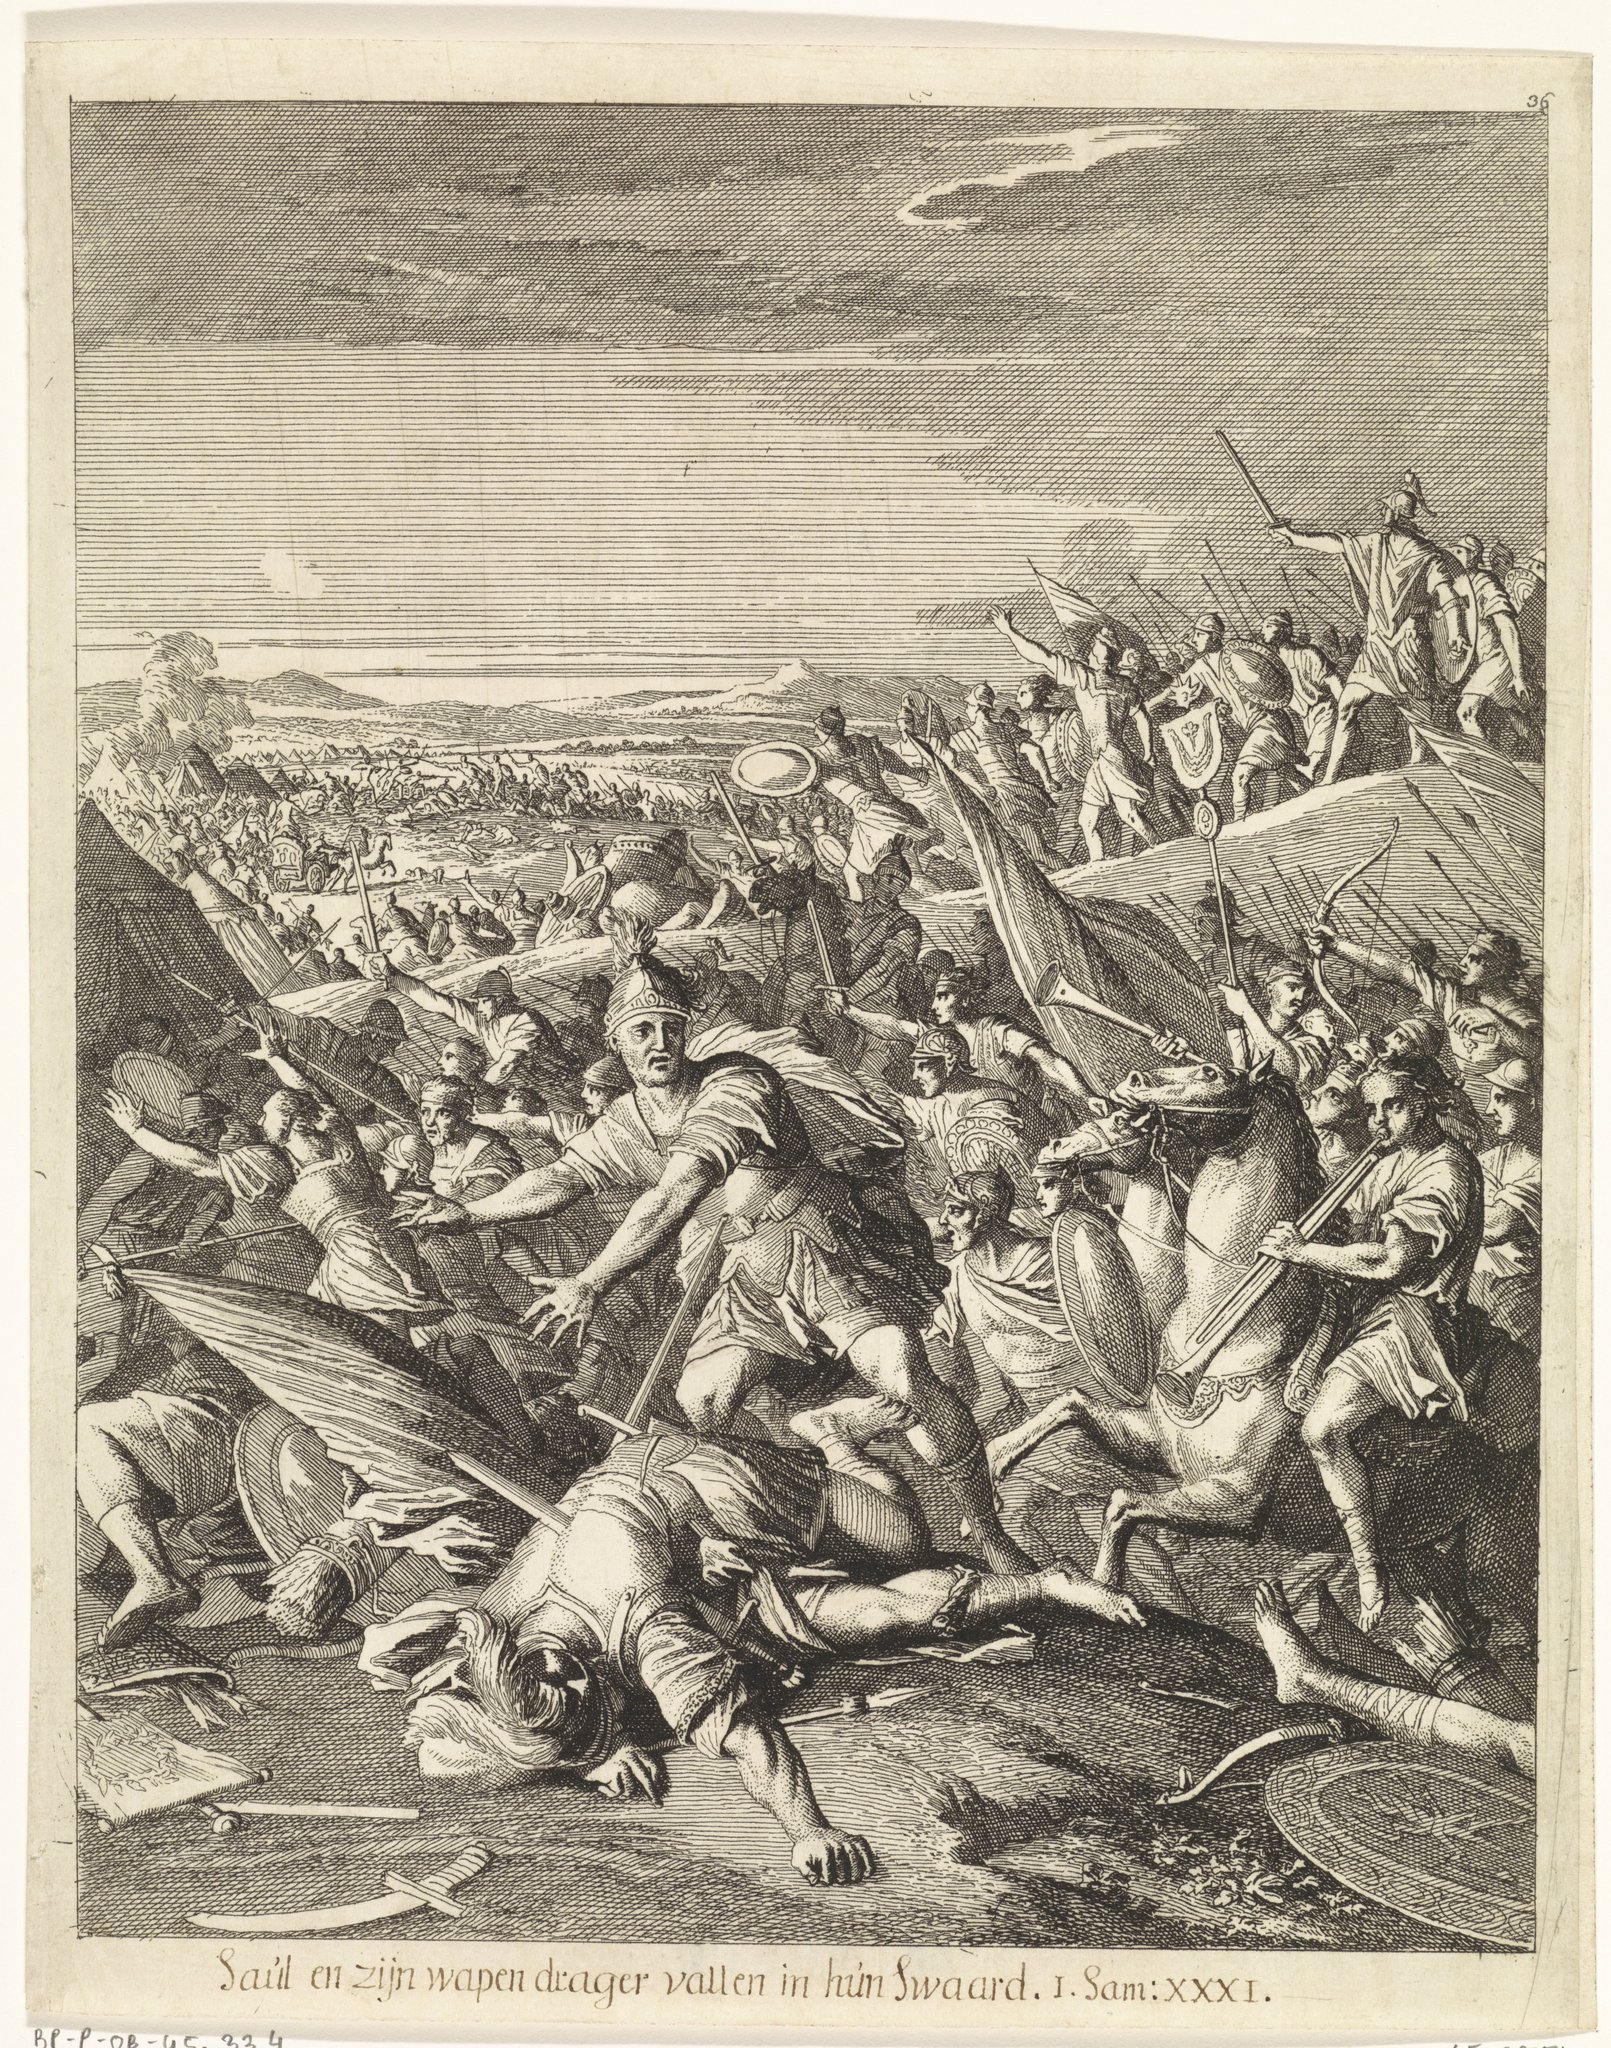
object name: print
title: Sauls dood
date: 1708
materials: paper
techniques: etching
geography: nuremberg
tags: saul's death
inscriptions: collector's mark: Lugt 2228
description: Proefdruk van een prent welke is opgenomen als illustratie in: Historiae Celebriores Veteris Testamenti. Christoph Weigel, 1708.